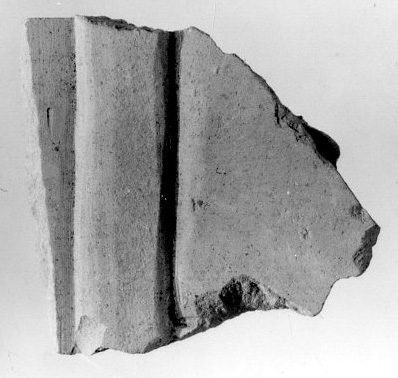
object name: relief fragment, tomb of meketre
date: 1981-1975 BCE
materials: limestone, paint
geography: egypt